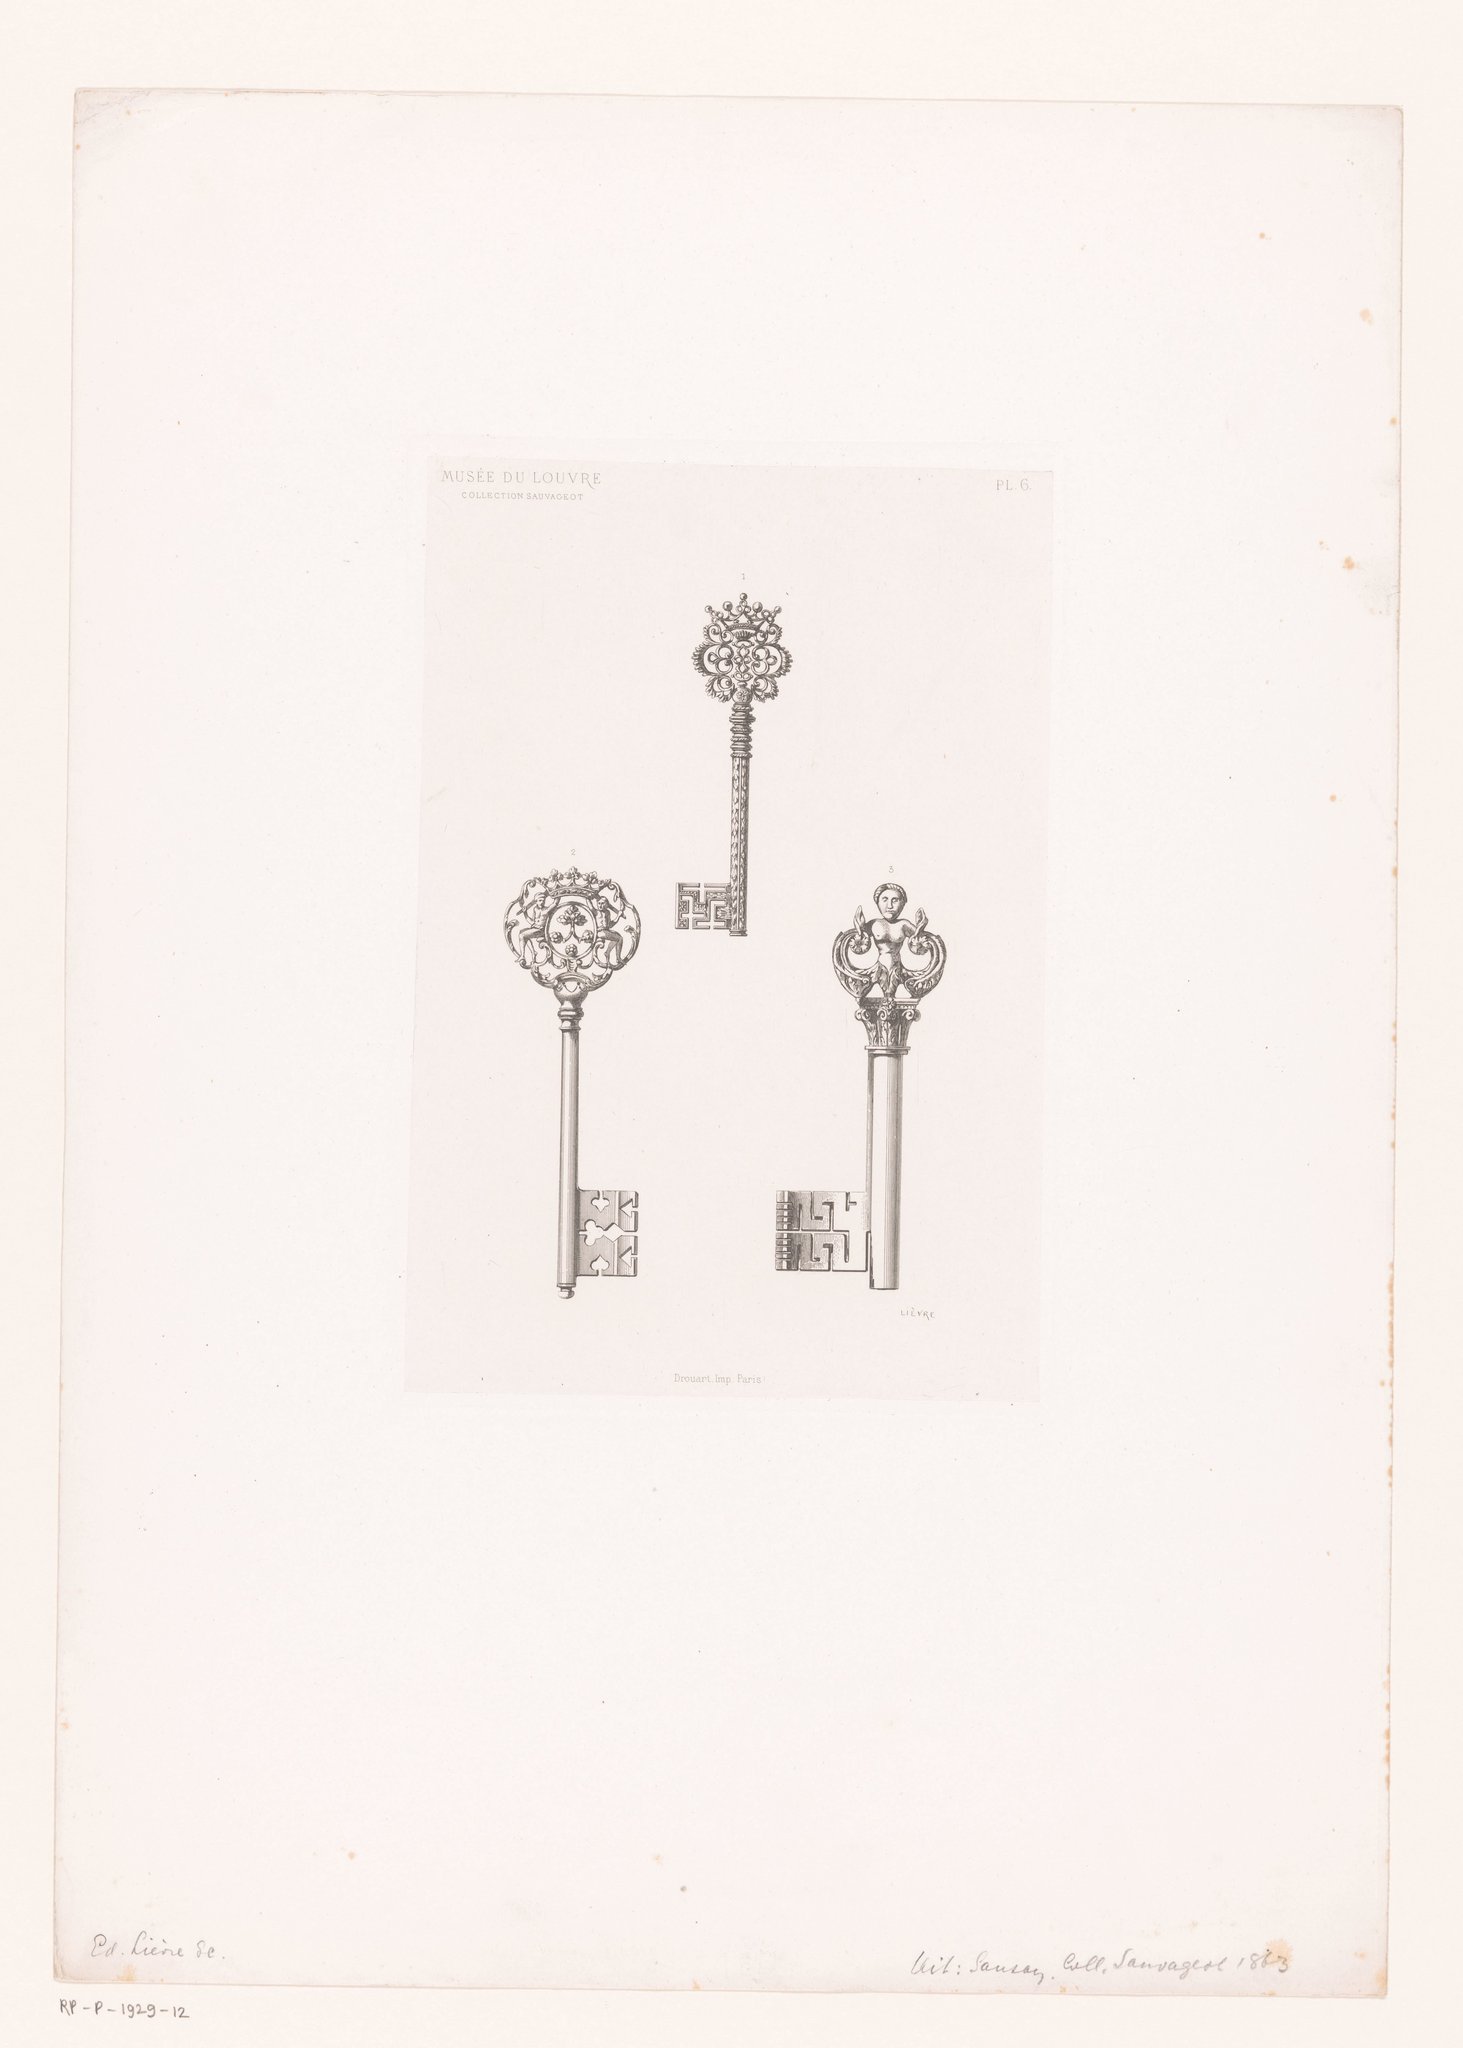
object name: print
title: Drie sleutels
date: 1863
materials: paper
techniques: etching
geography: paris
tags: key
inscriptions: collector's mark: Lugt 2228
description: Prent uit: Sauzay, Alexandre. Musée Impérial Du Louvre - Collection Sauvageot Dessinée Et Gravée A L'Eau-Forte Par Édouard Lièvre Accompagnée D'Un Texte Historique Et Descriptif Par A. Sauzay. Parijs: Noblet et Baudry, 1863. In deze publicatie worden metalen objecten beschreven uit de Gotiek en de Renaissance uit de collectie van Charles Sauvageot, in 1856 geschonken aan het Musée du Louvre.